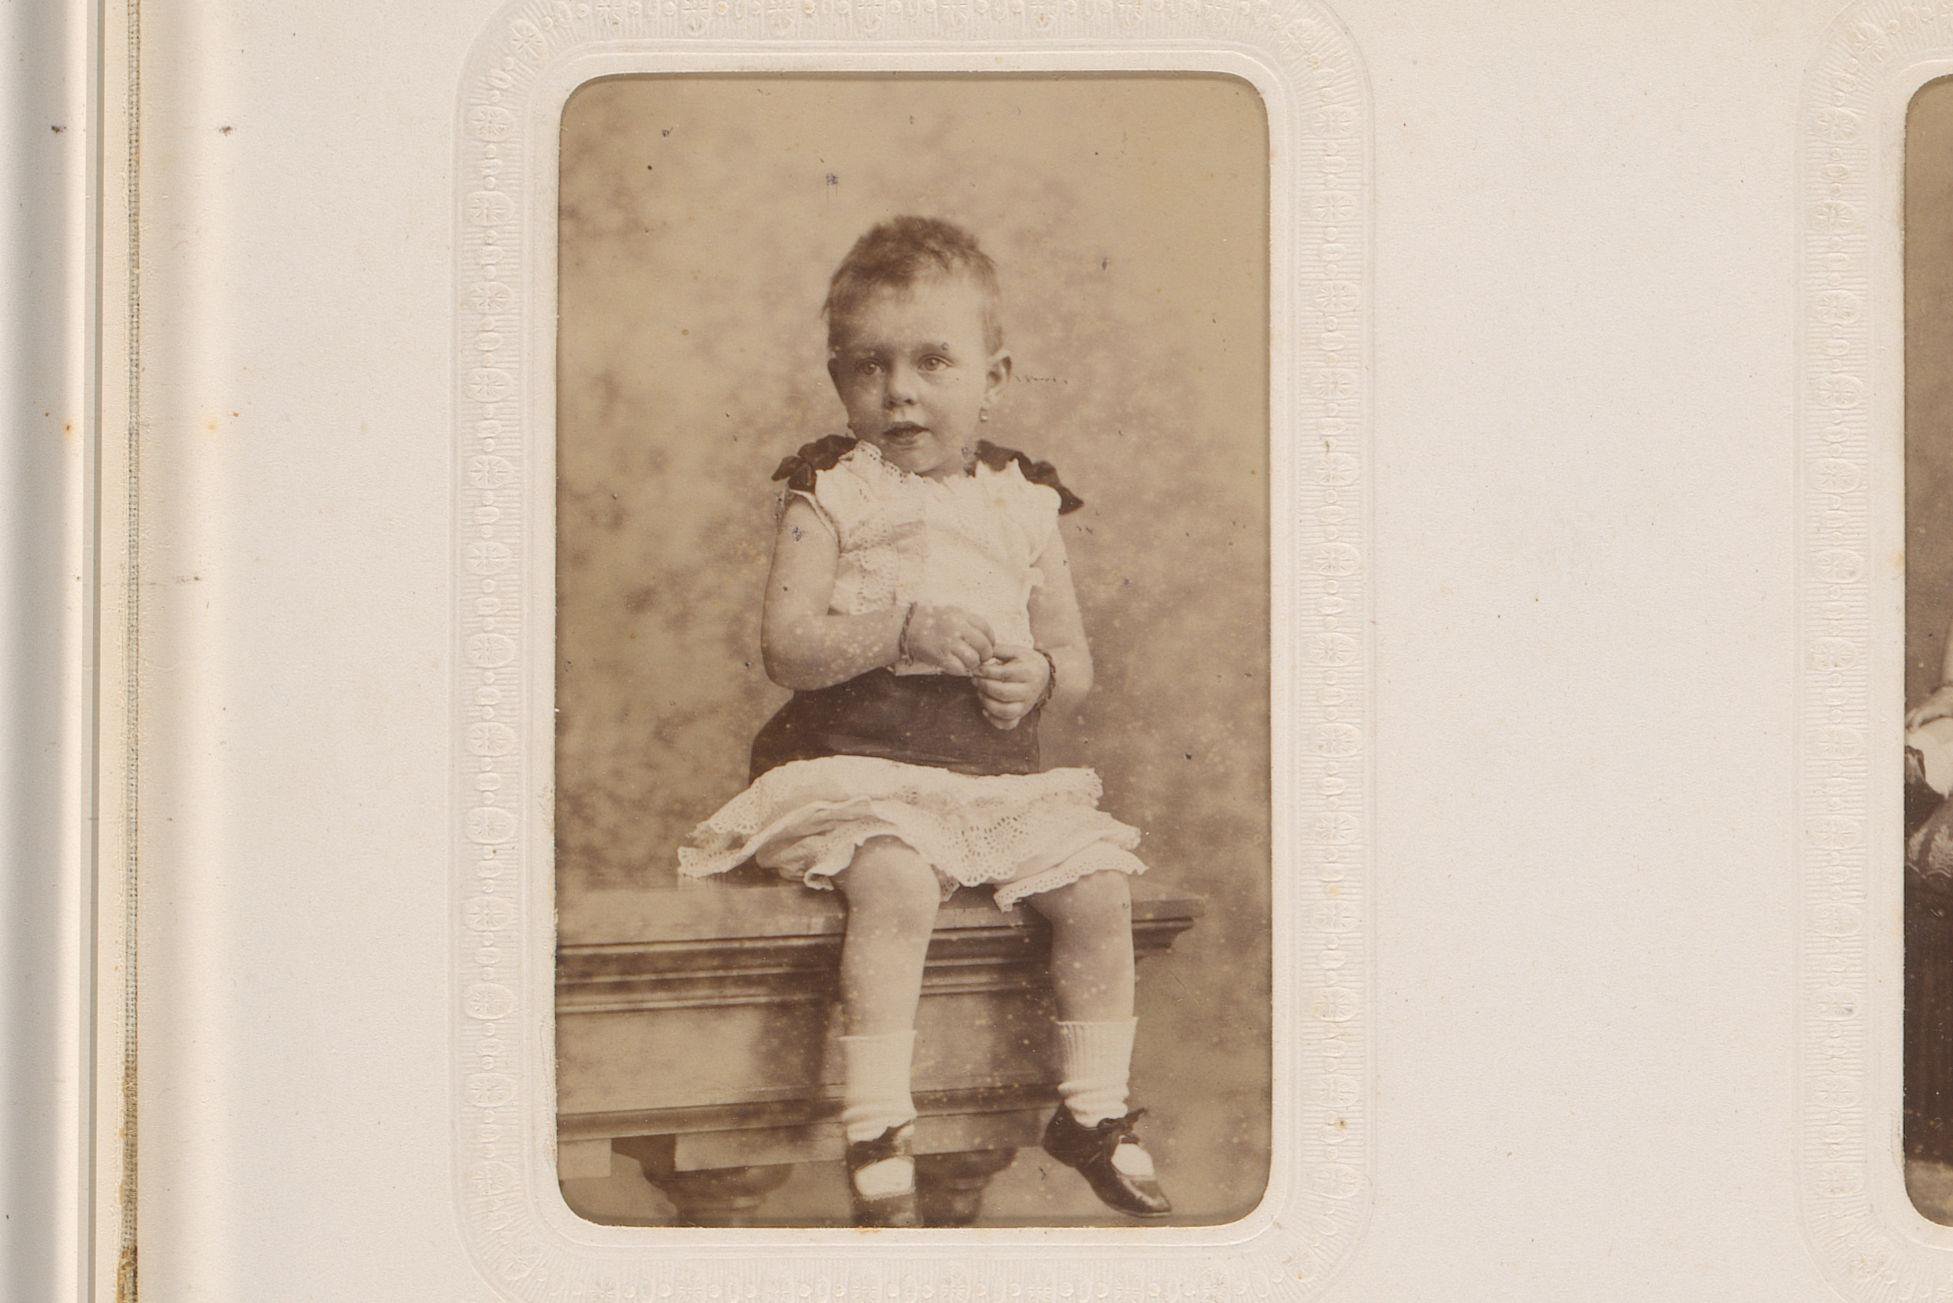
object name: carte de visite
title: Portret van een staand meisje, leunend op de zitting van een stoel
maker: louis robert werner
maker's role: fotograaf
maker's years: 1834-1896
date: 1860-1896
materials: cardboard, photographic support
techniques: albumen print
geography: netherlands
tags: historical persons - bb - woman, leaning figure - aa - female human figure, toddler (female), chair